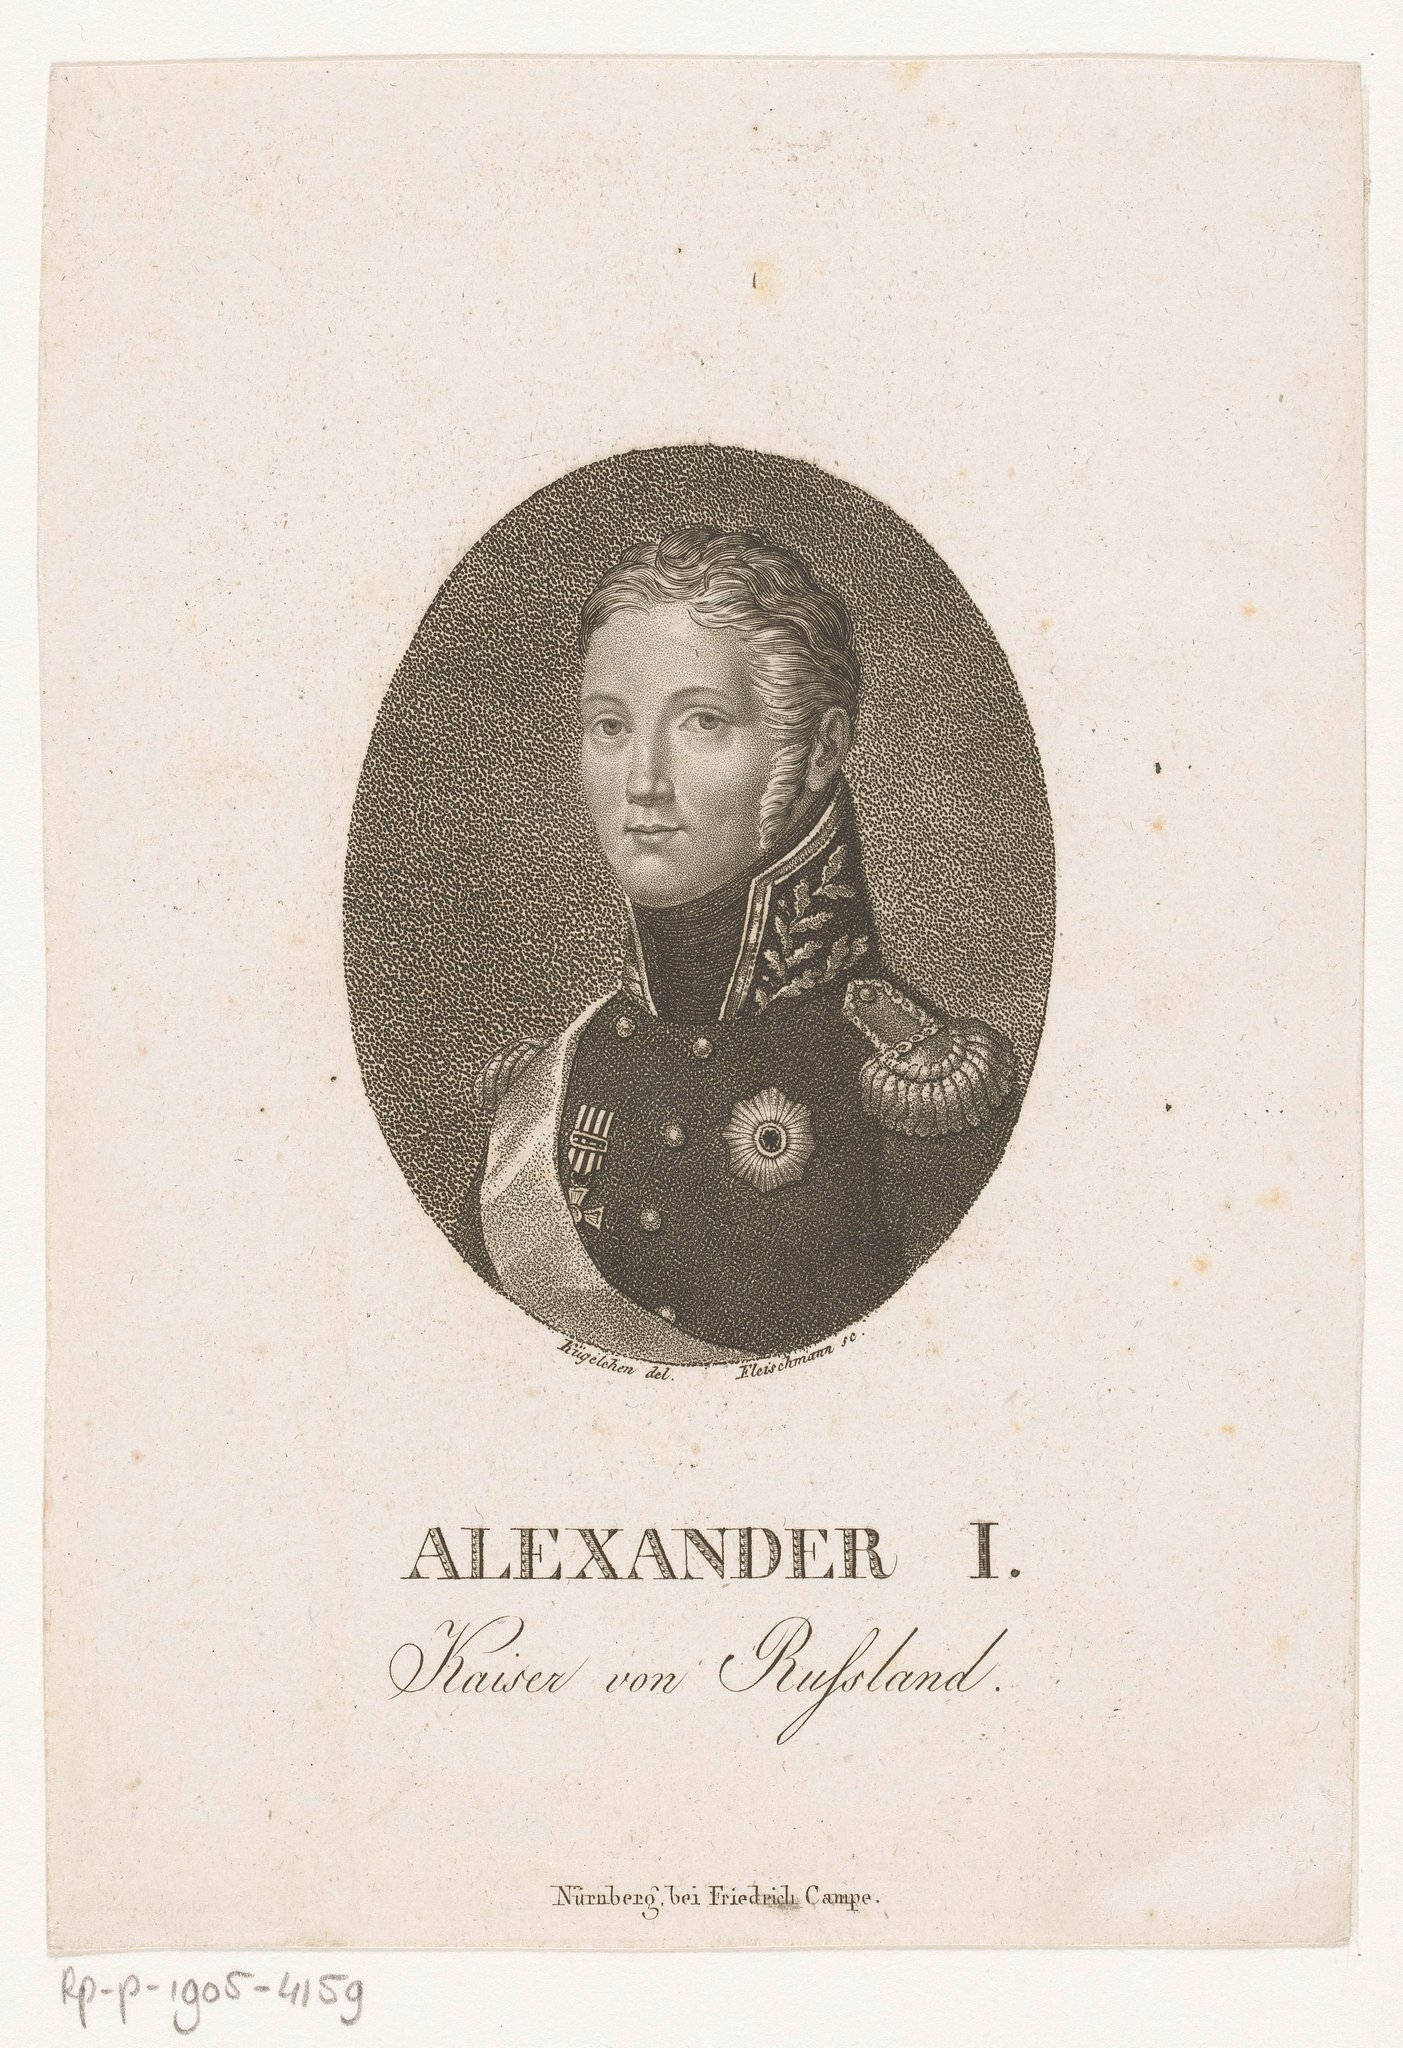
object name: print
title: Portret van Alexander I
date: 1801-1834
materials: paper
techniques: etching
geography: nuremberg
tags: alexander i (tsaar van rusland), knighthood order (with name) - insignia of a knighthood order, e.g.: badge, chain (with name of order), knighthood order, historical persons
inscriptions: collector's mark: Lugt 2228